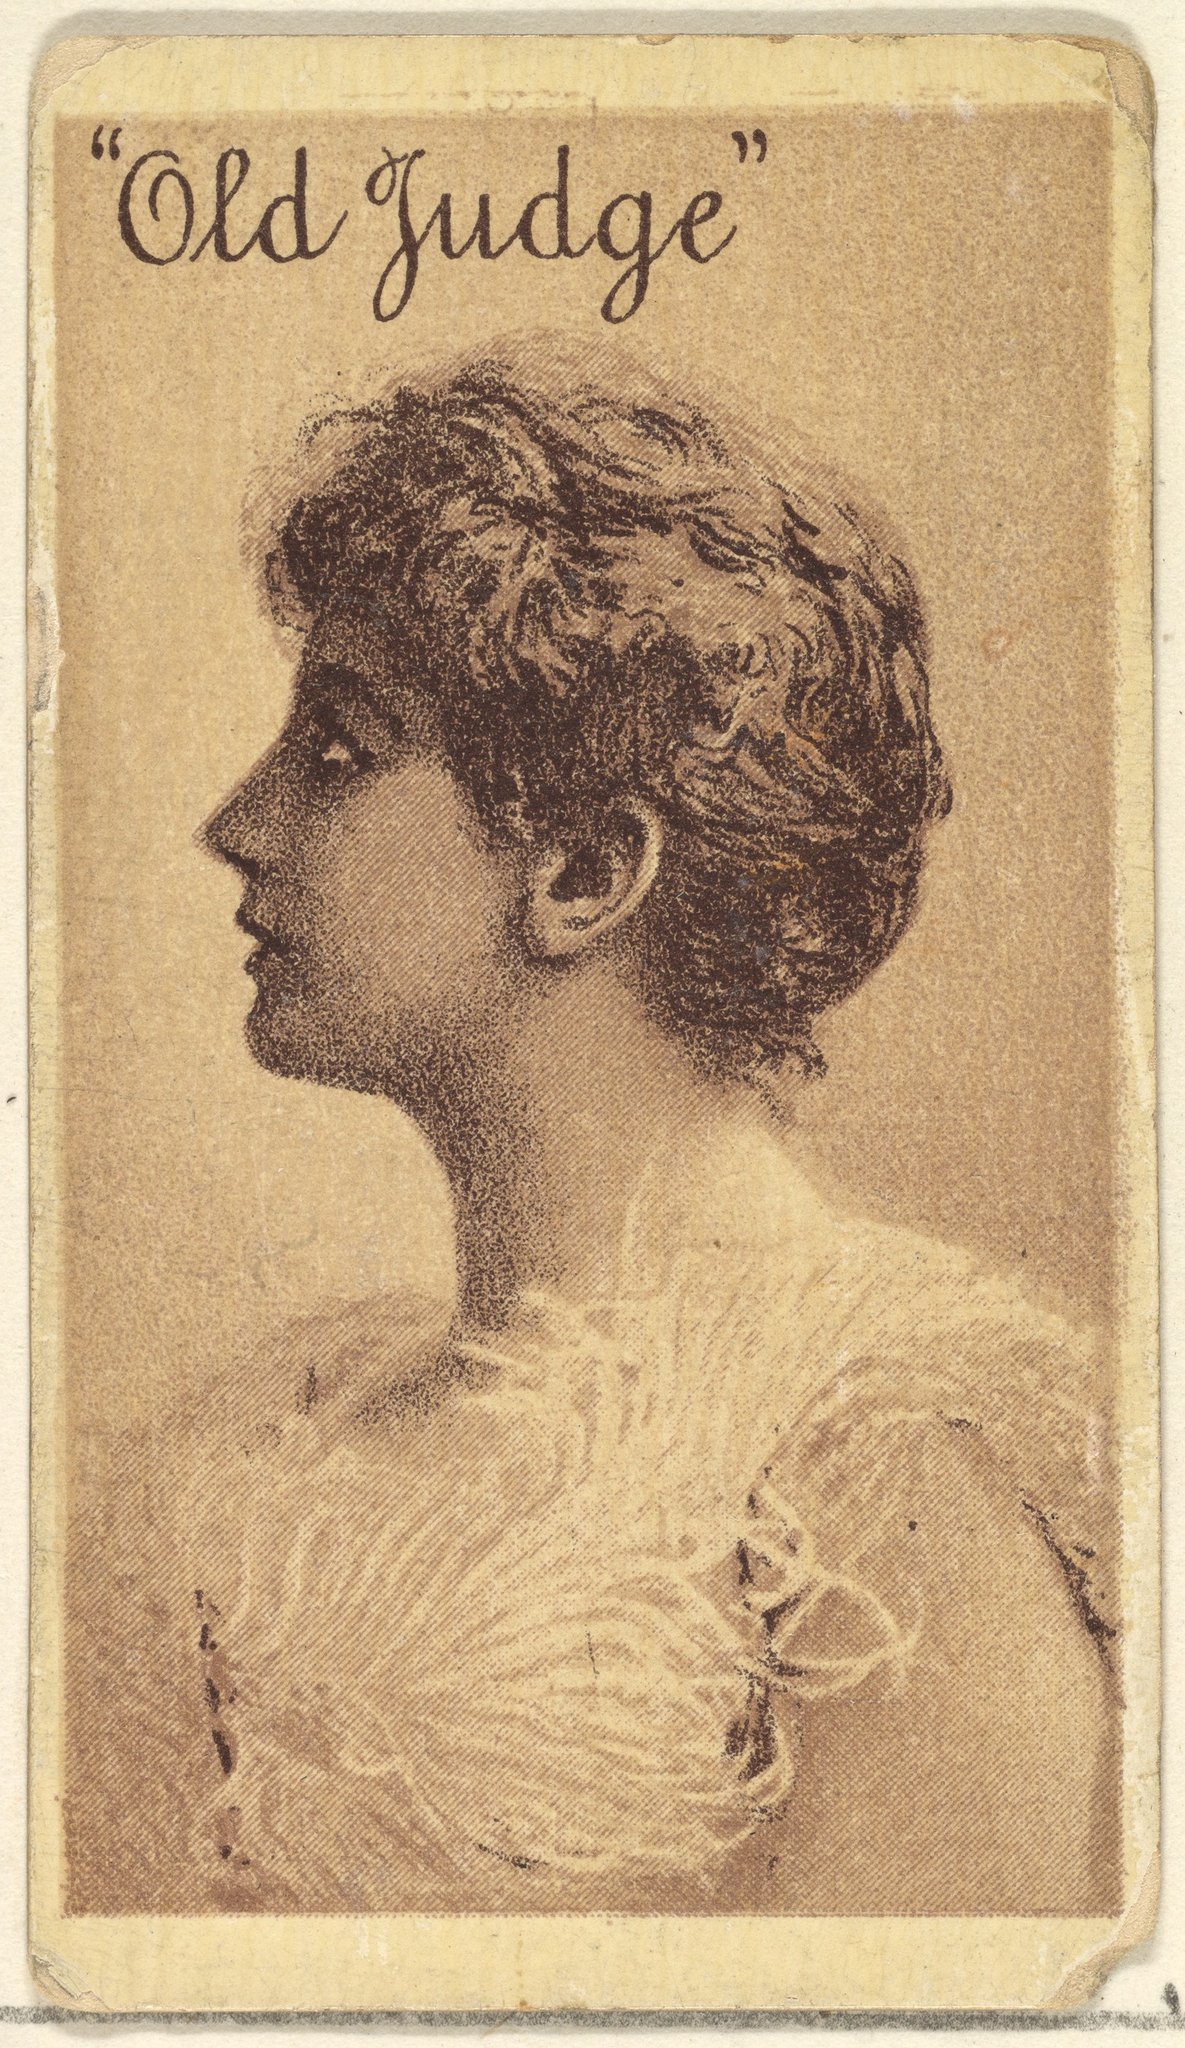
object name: print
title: Actress from the Old Judge series (N167) for Old Judge Cigarettes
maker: goodwin & company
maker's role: publisher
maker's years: 1850-1950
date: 1886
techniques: lithography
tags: women